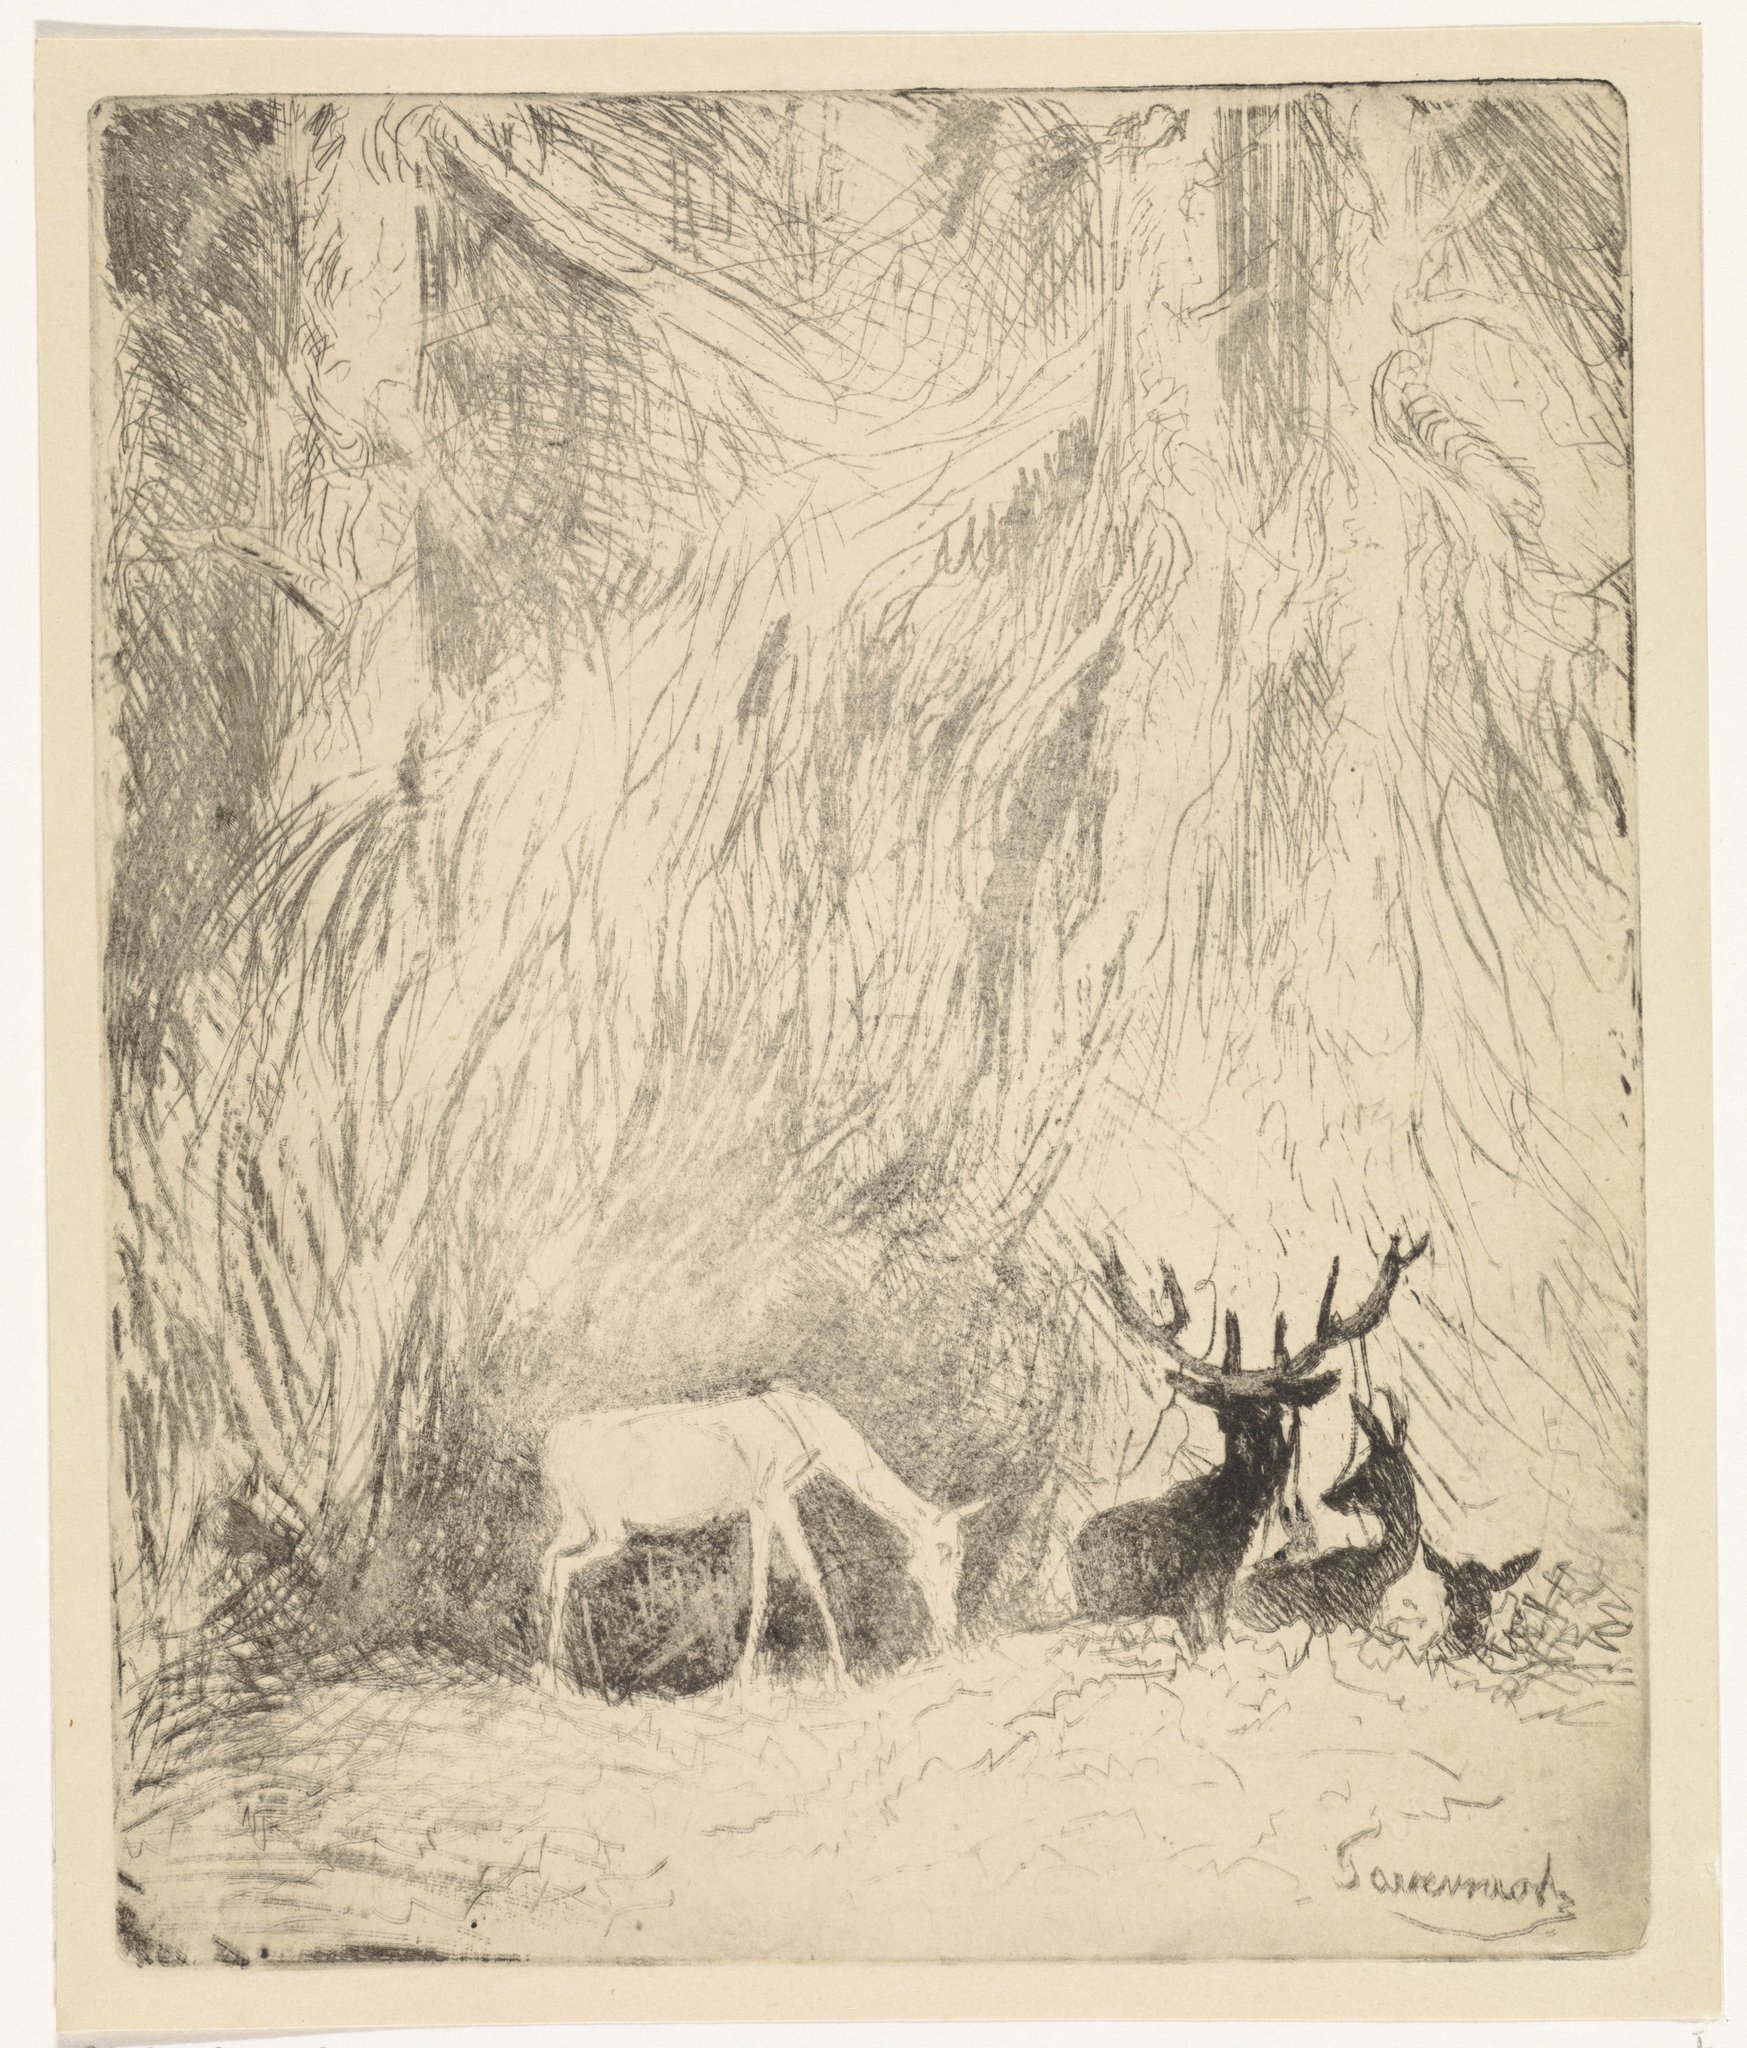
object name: print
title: Herten in een Boheems woud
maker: johannes tavenraat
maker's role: draughtsman, painter, print maker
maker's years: 1809-1881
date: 1819-1881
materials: paper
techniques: etching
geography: cleves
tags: hoofed animals: deer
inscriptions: collector's mark: Lugt 2228